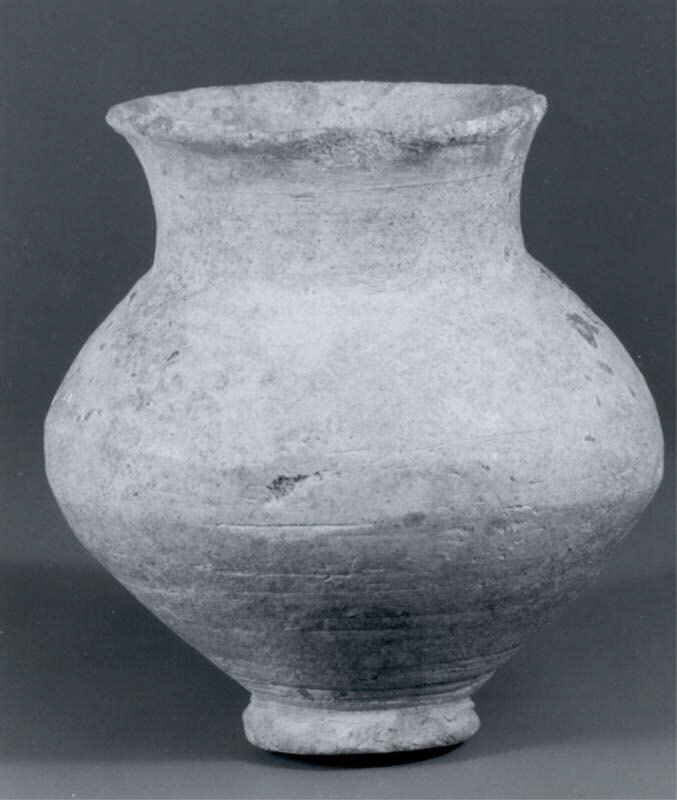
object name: jar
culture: iranian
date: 1700-1501 BCE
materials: ceramic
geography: iran